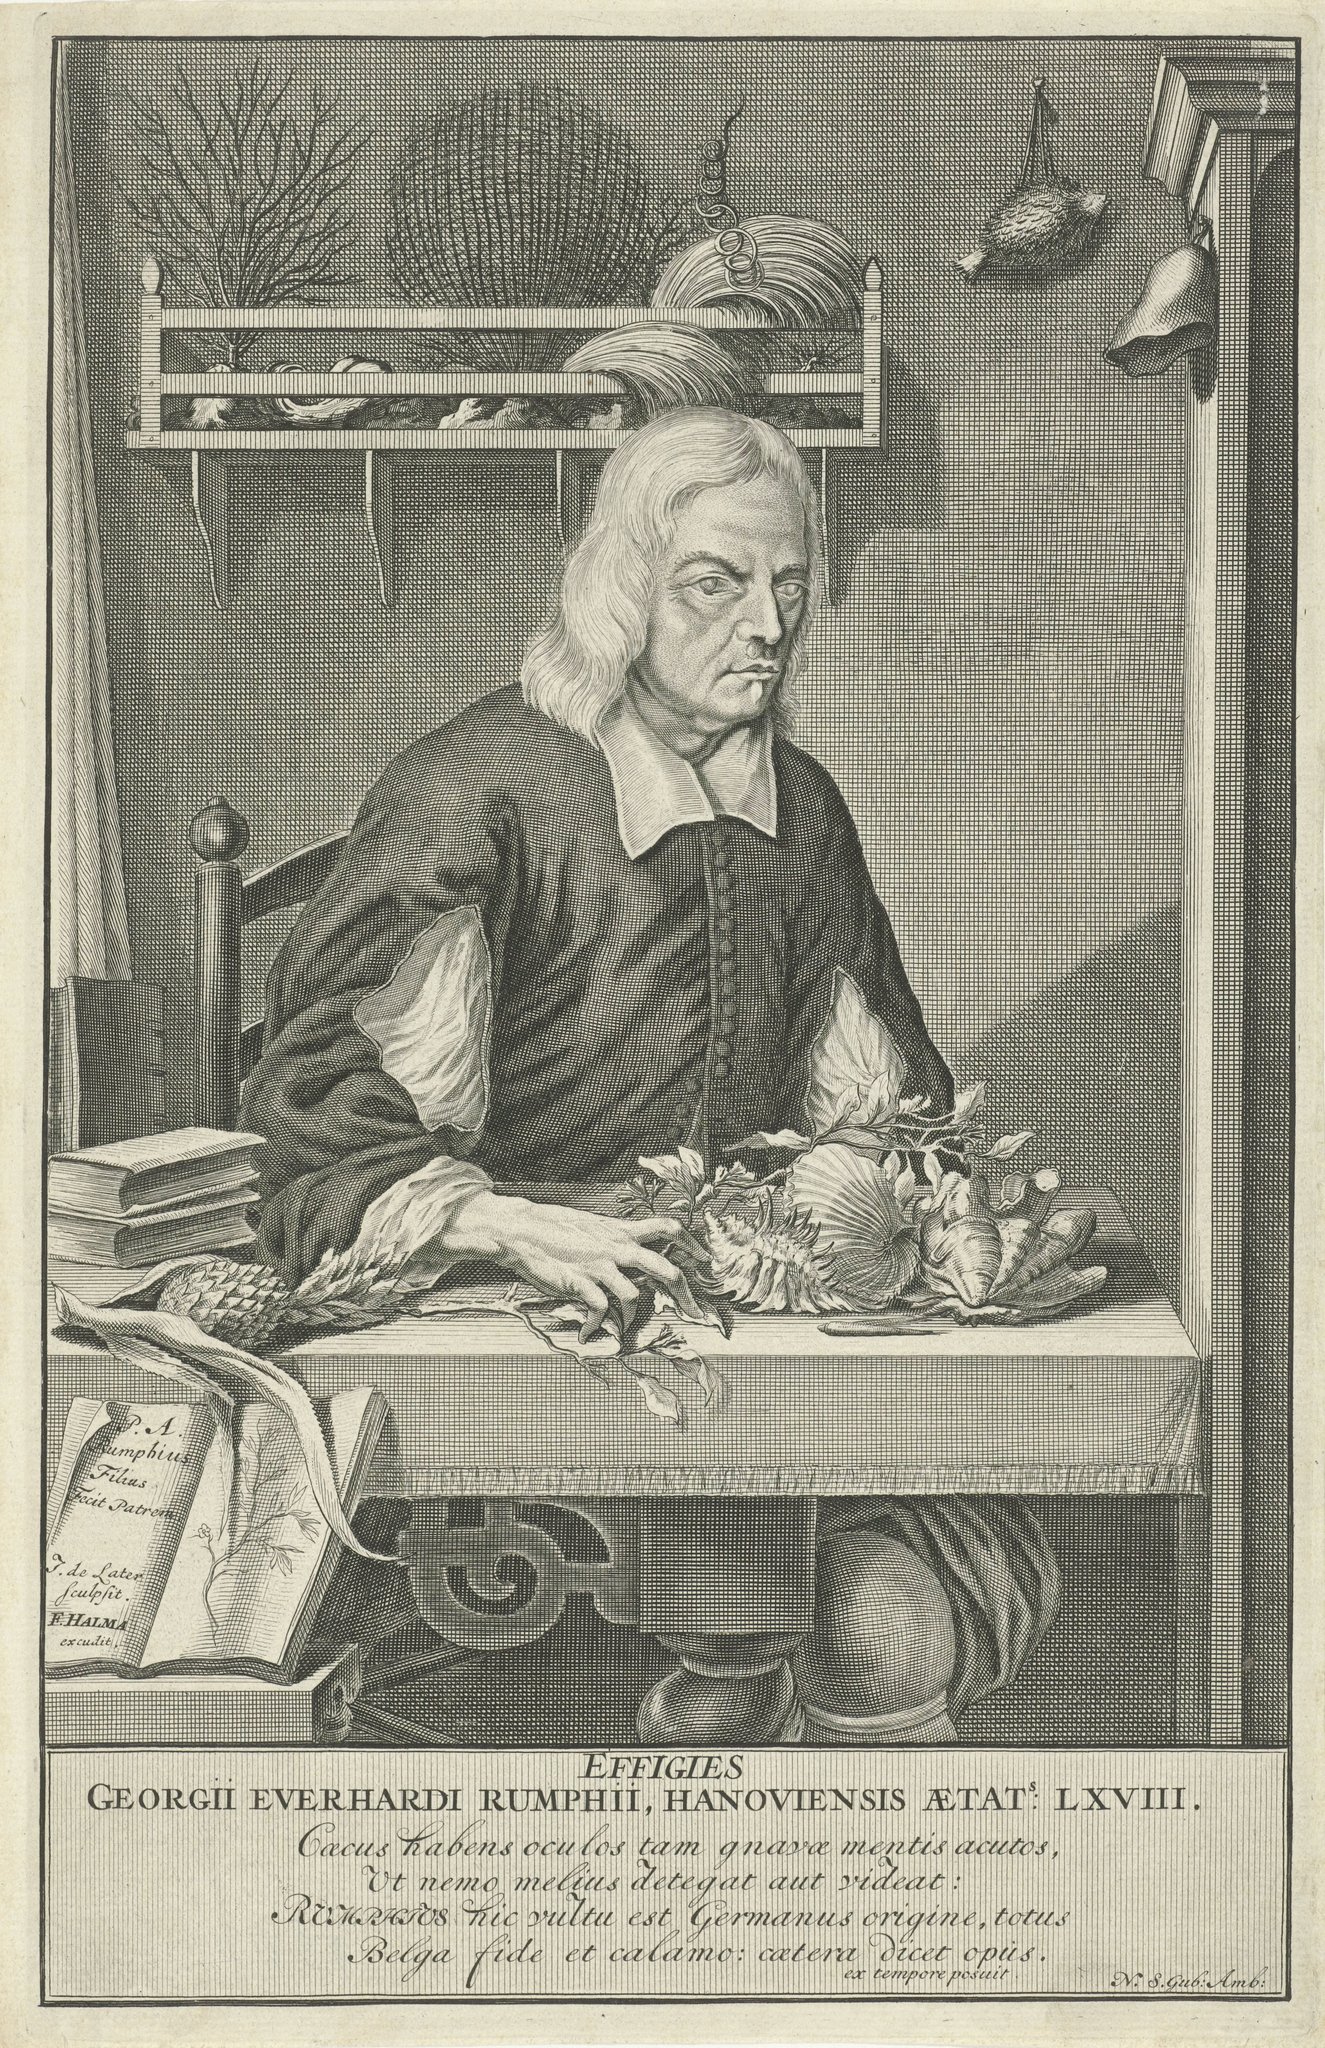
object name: print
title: Portrait of Georg Everhard Rumphius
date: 1696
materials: paper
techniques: engraving, etching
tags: georg everhard rumphius, biology (+ scholar, scientist in non-work situations), study; 'studiolo'; library, botany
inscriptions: collector's mark: Lugt 2228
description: Georg Everhard Rumphius, geleerde en natuuronderzoeker op Ambon, in zijn studeervertrek. Hij zit aan een tafel waarop boeken, planten en schelpen. Tegen de wand een rekje met koraal en andere vondsten uit de zee. Links op de voorgrond staat een opengeslagen boek van Rumphius zelf opgesteld. Onder het portret een tekst in Latijn.